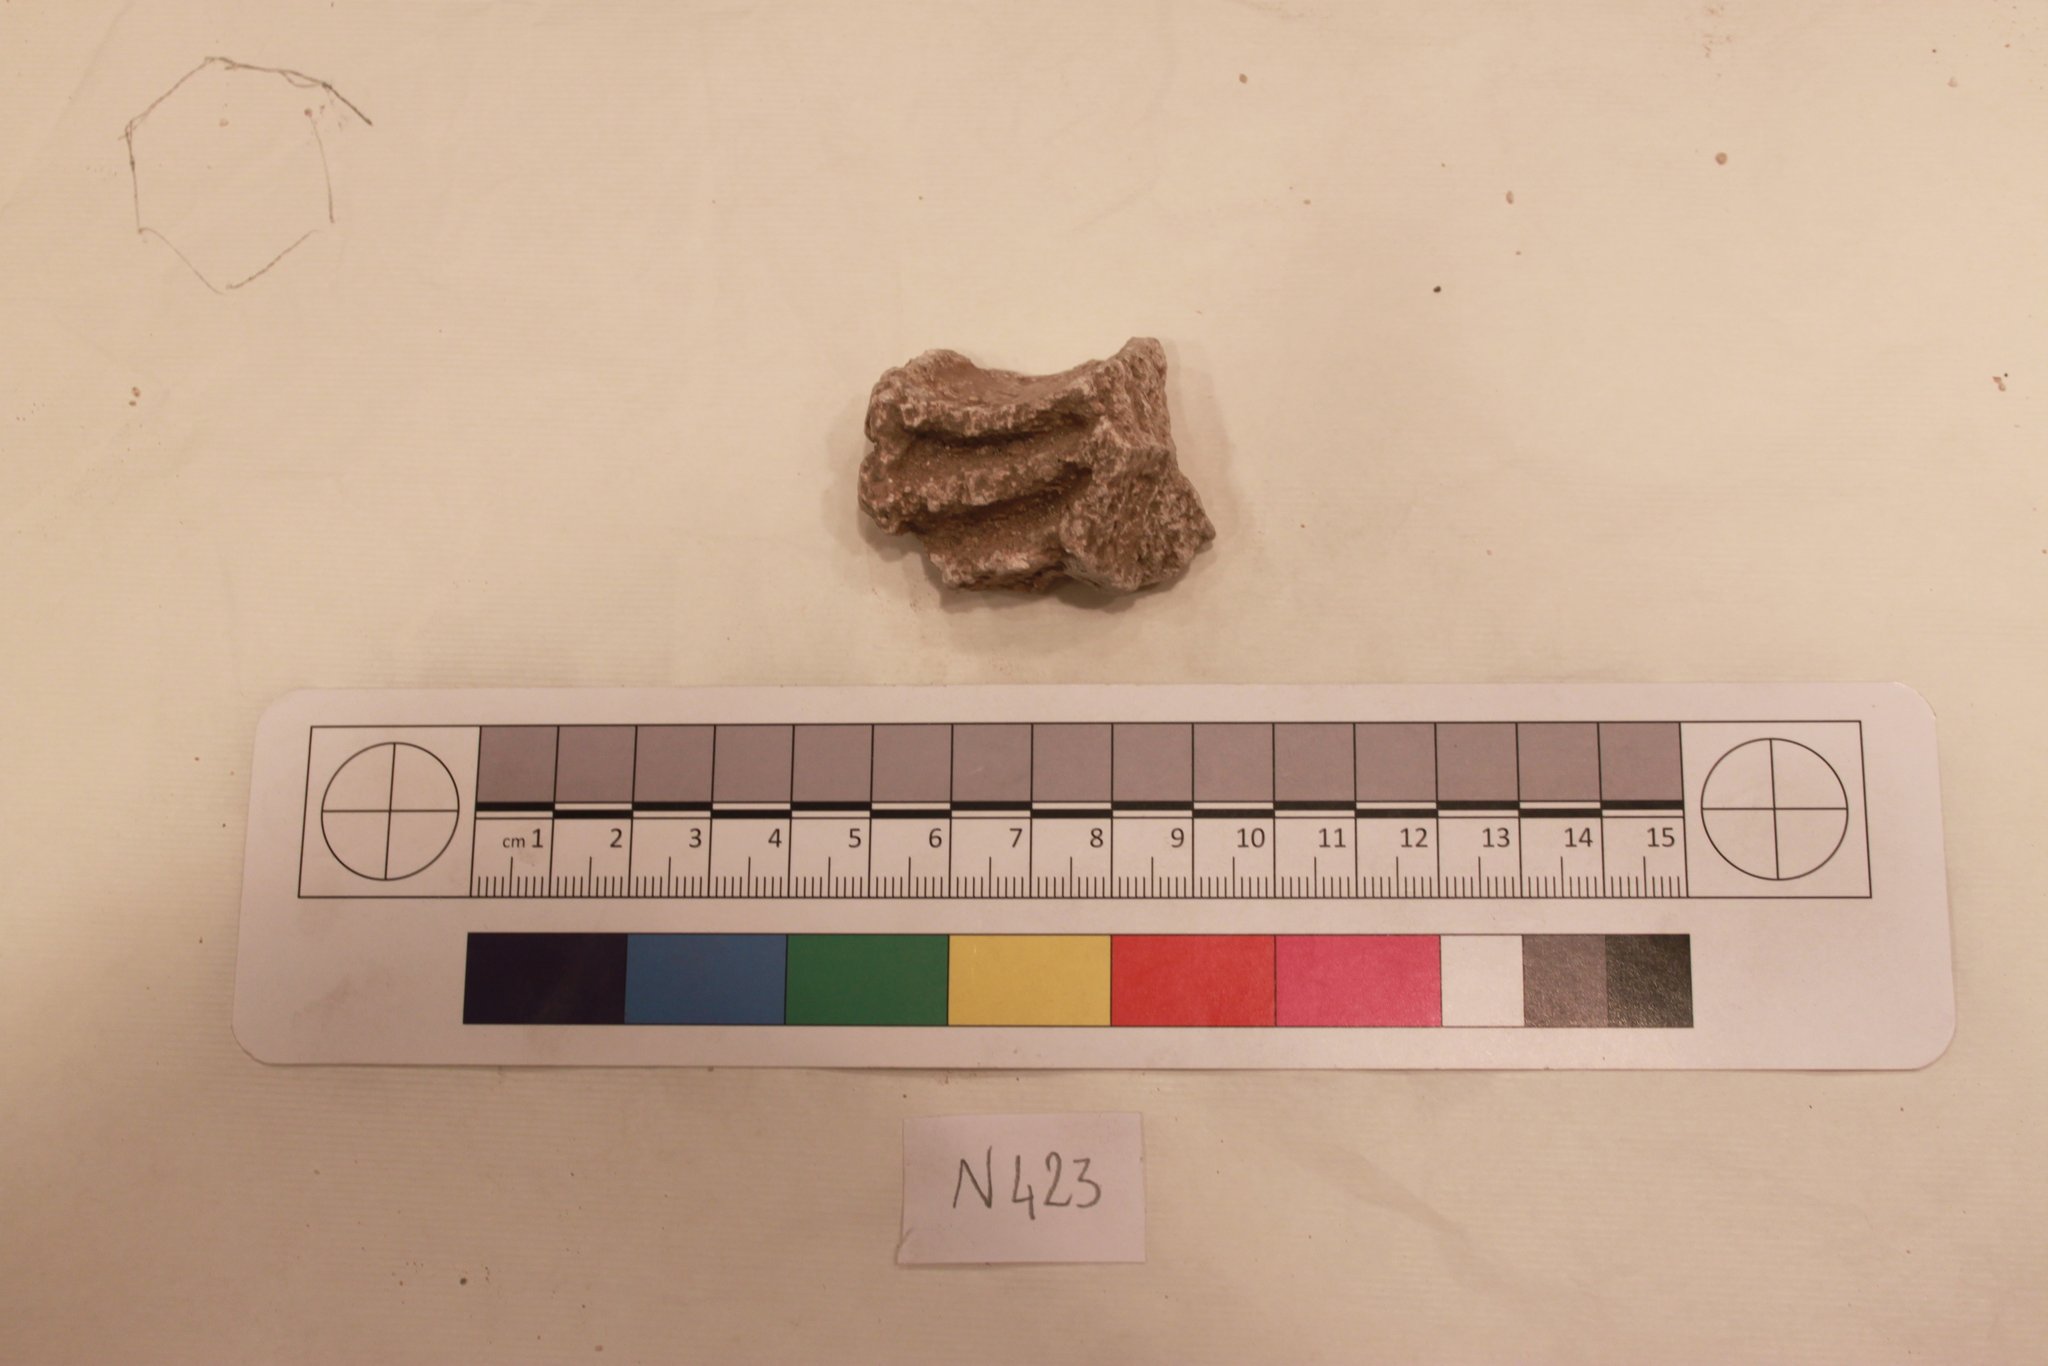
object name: fragment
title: Stucco Fragment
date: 701-1200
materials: plaster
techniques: carving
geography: iran